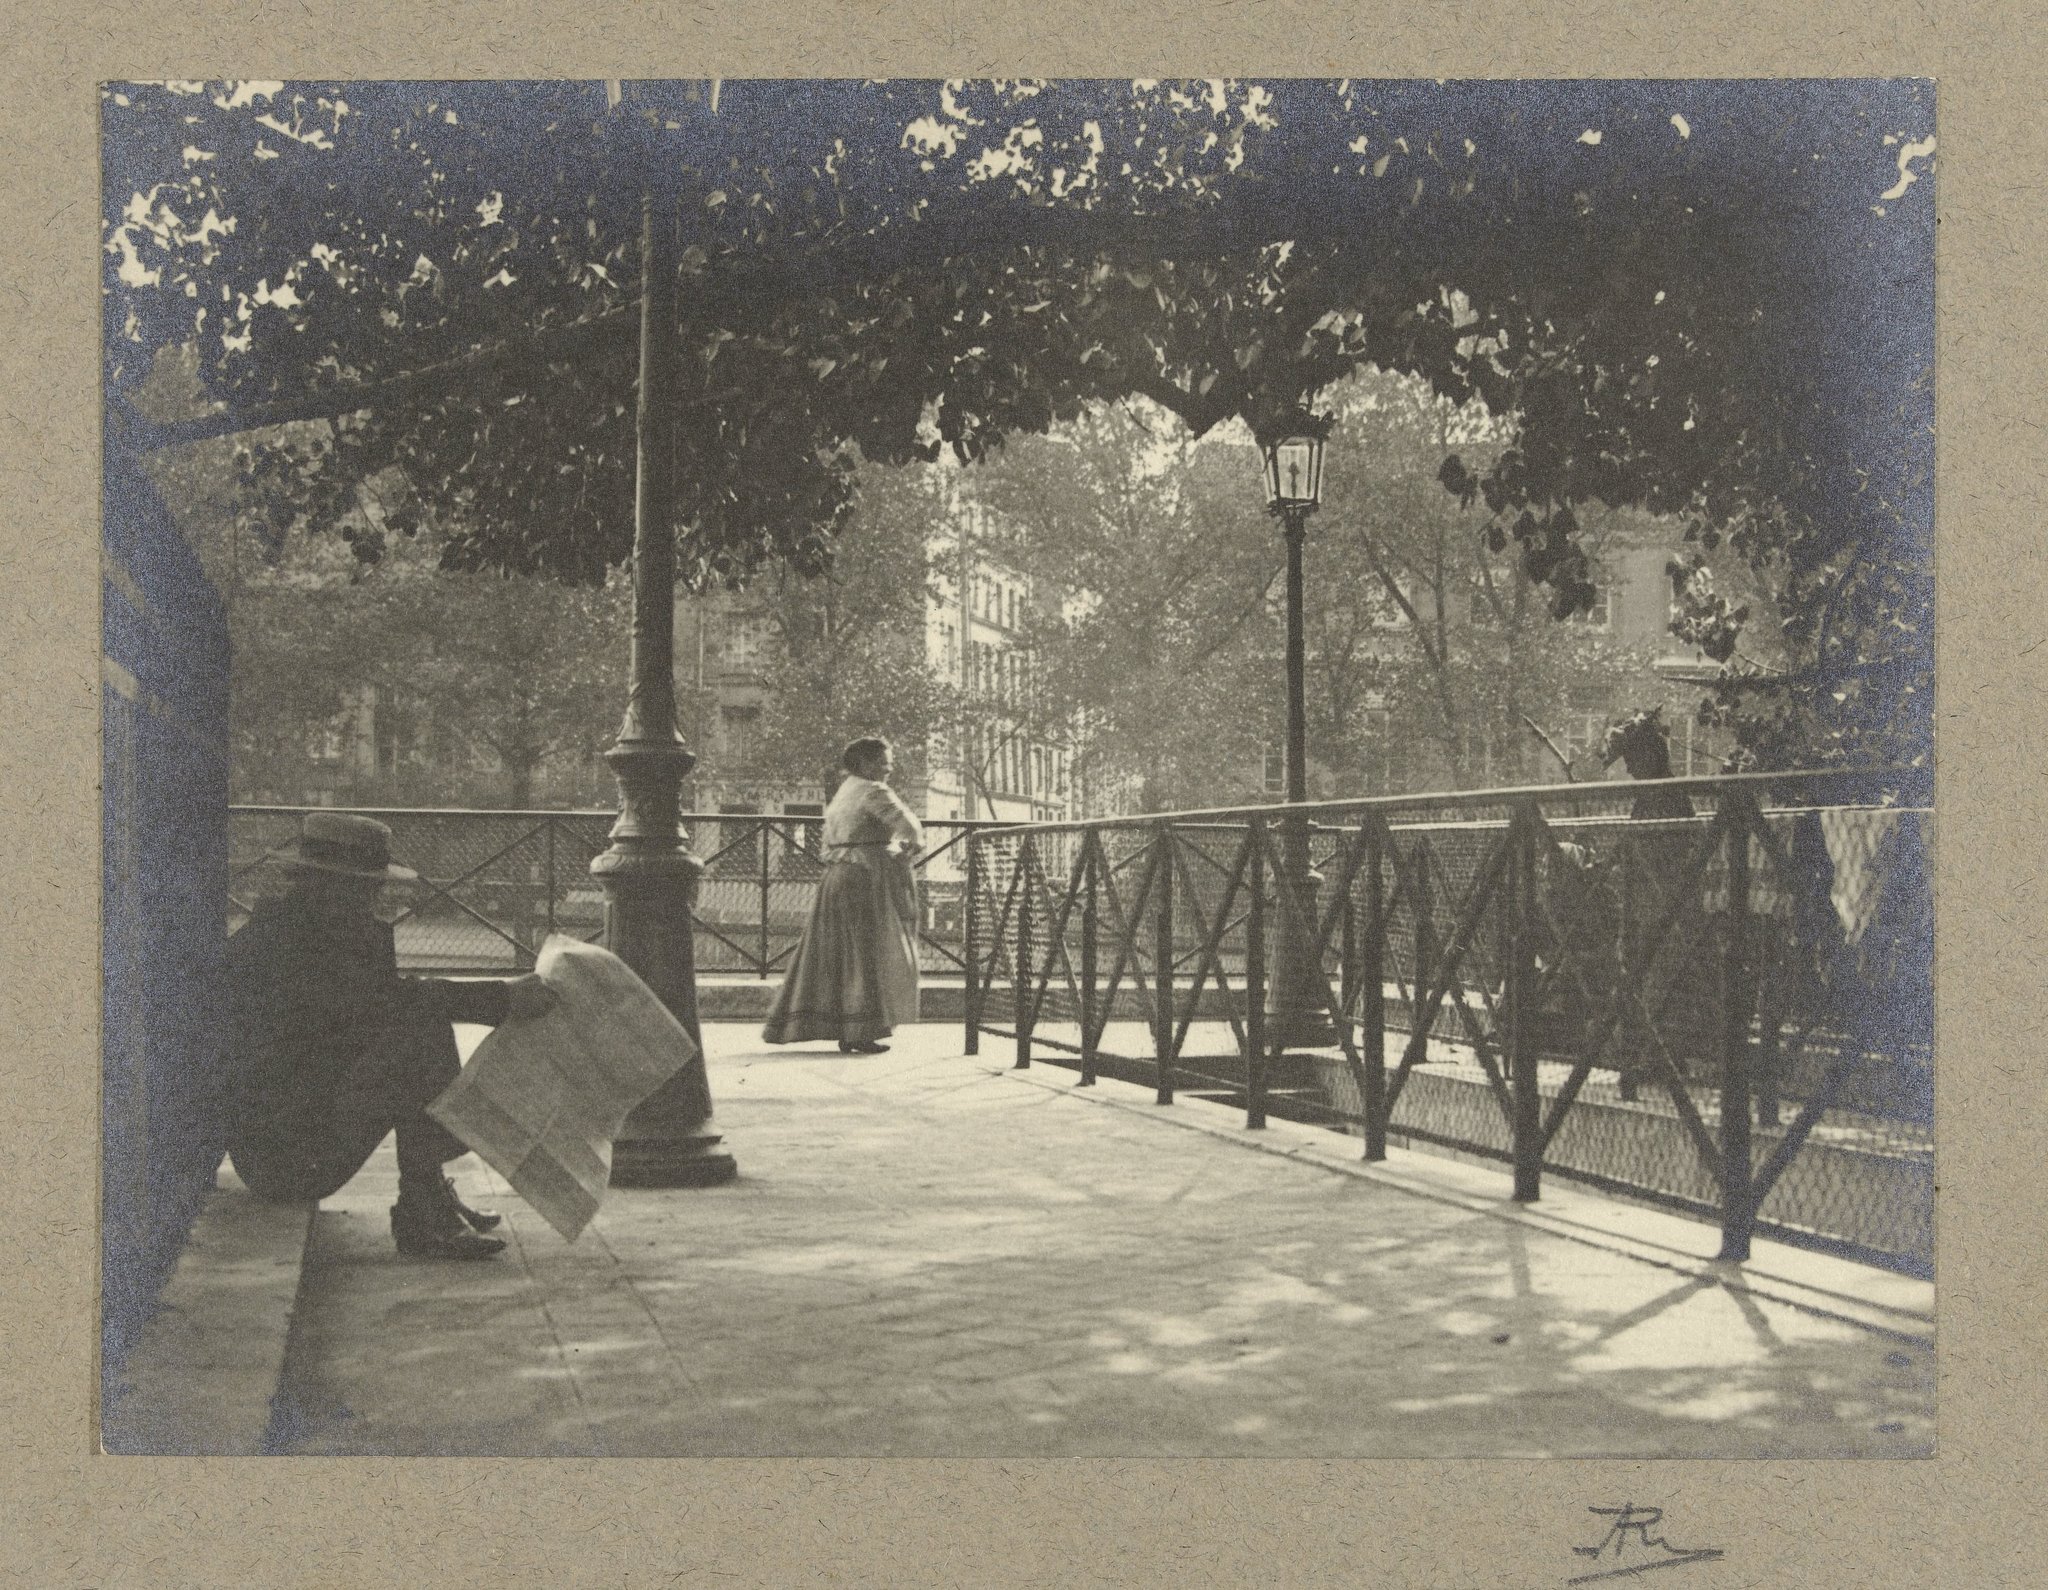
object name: photograph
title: Pont Neuf over de Seine te Parijs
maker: a. roussel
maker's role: fotograaf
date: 1904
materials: paper, cardboard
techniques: gelatin silver print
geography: france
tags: bridge in city across river, canal, etc., newspaper, news-sheet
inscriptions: inscription: ‘Platforme du Pont Neuf/ Salon de Paris 1904/ Andre Roussel’, signature: ‘A Roussel’